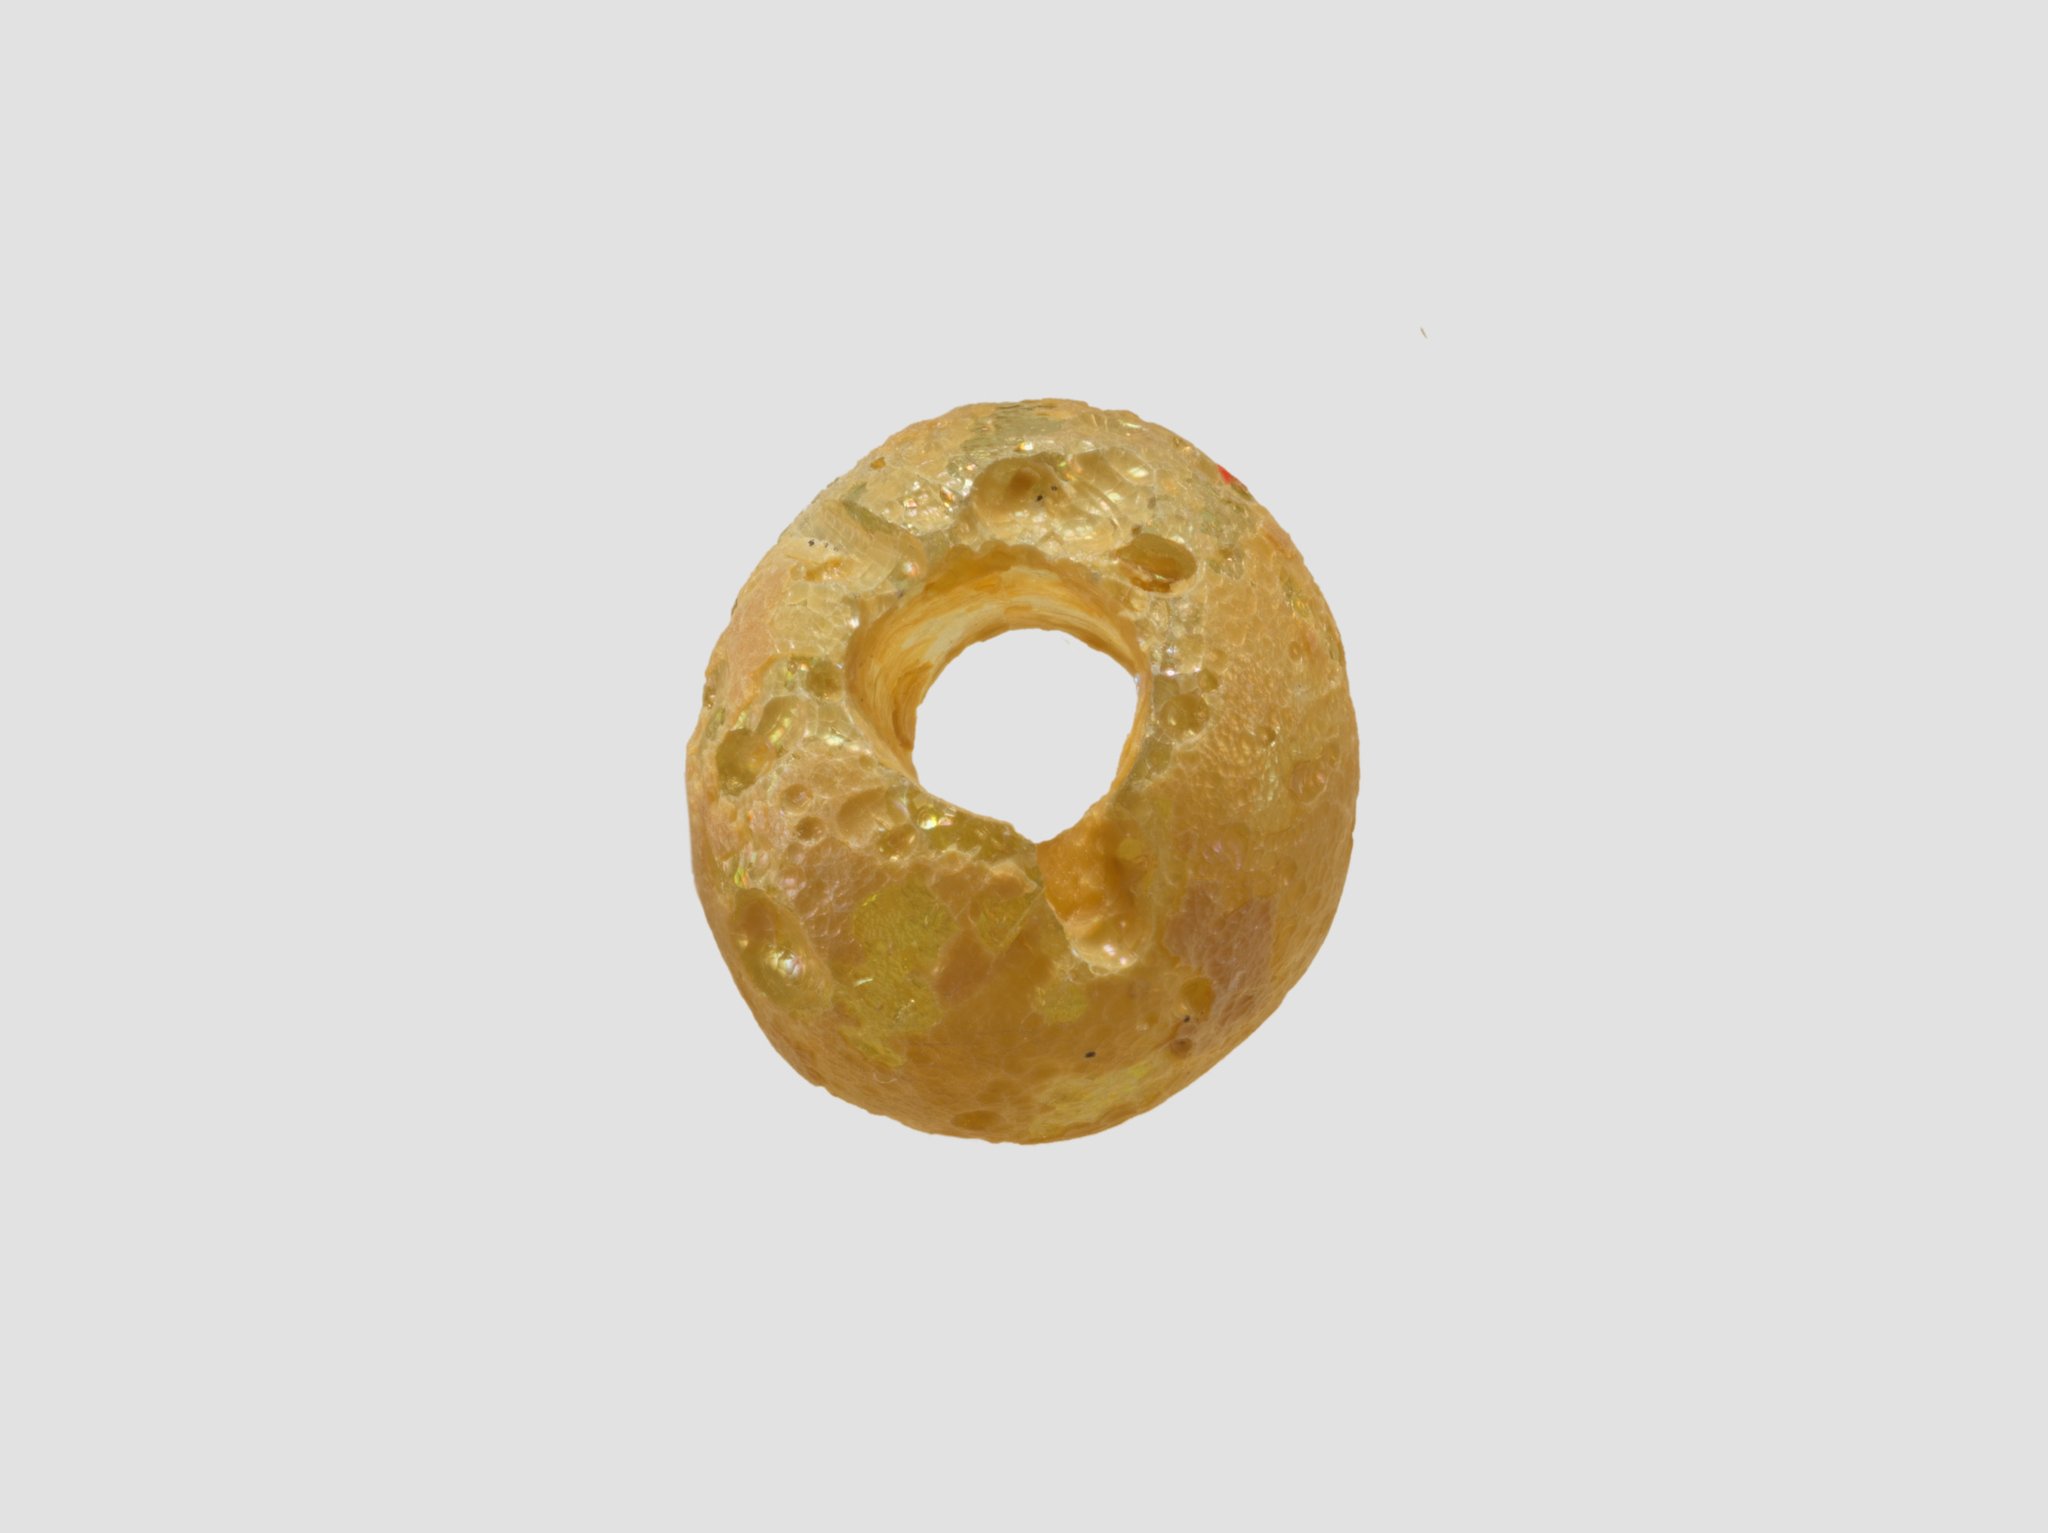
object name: bead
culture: iranian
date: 700-601 BCE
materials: glass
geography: iran